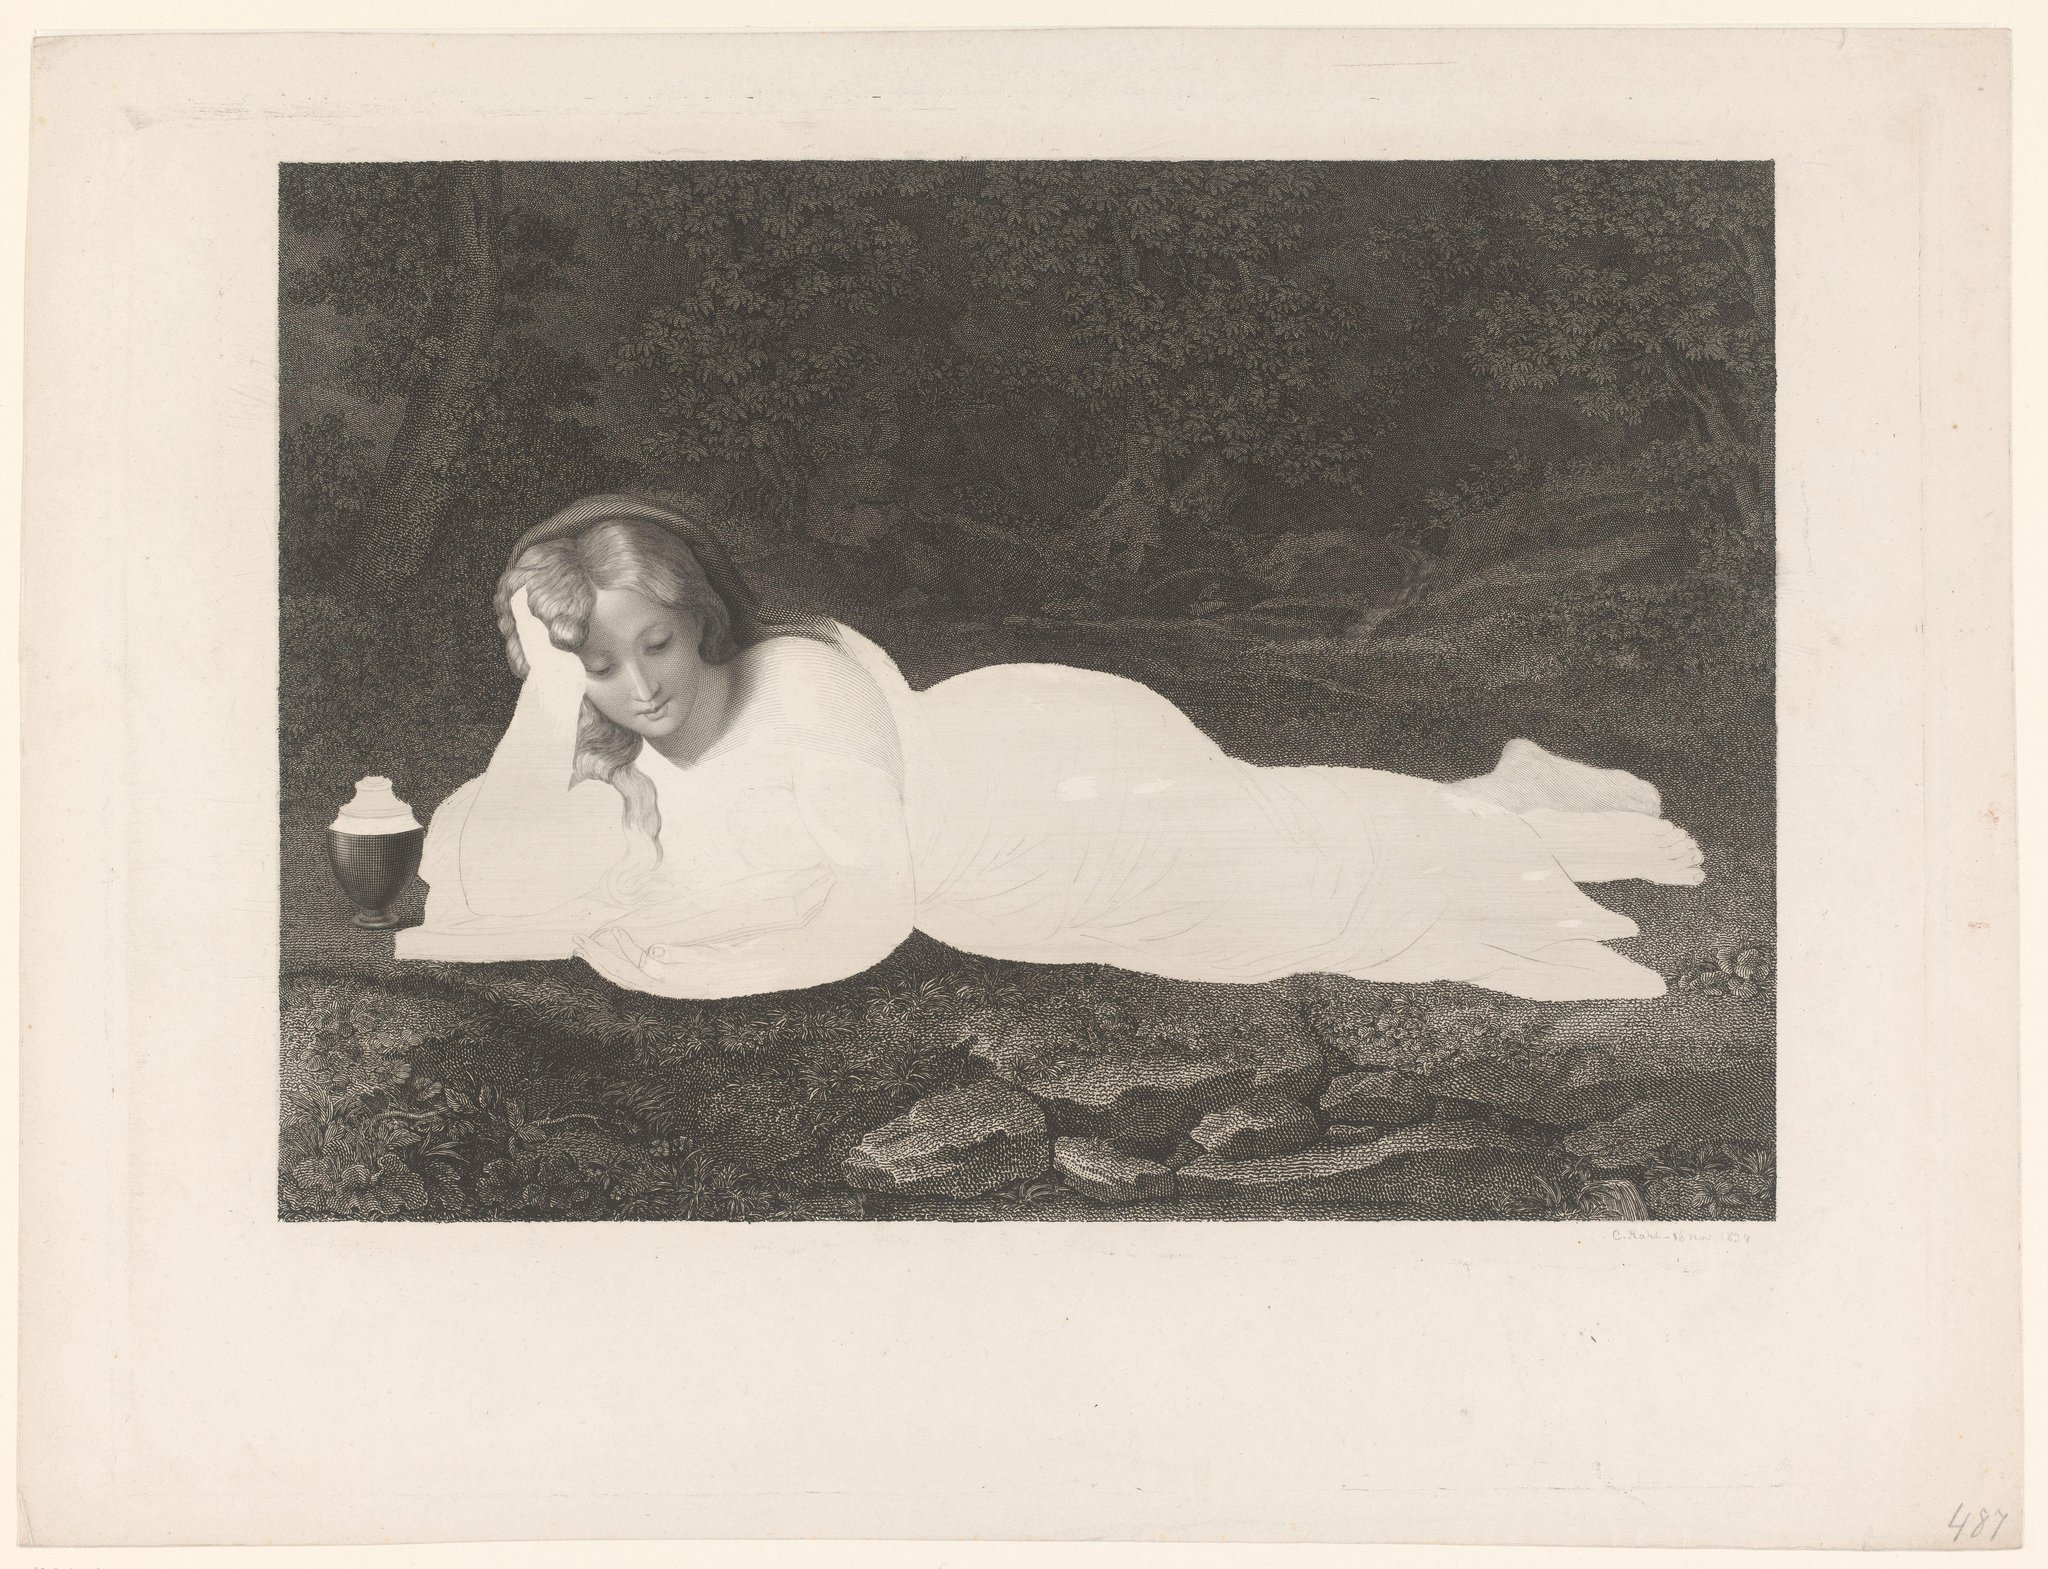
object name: print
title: Lezende Maria Magdalena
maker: carl rahl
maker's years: 1812-1865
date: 1826-1827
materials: paper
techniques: engraving, etching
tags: reading, the penitent harlot mary magdalene; possible attributes: book (or scroll), crown, crown of thorns, crucifix, jar of ointment, mirror, musical instrument, palm-branch, rosary, scourge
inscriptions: inscription: ‘C. Rahl - 16 nov. 1834’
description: De lezende Maria Magdalena ligt op de grond met voor haar de zalfpot.